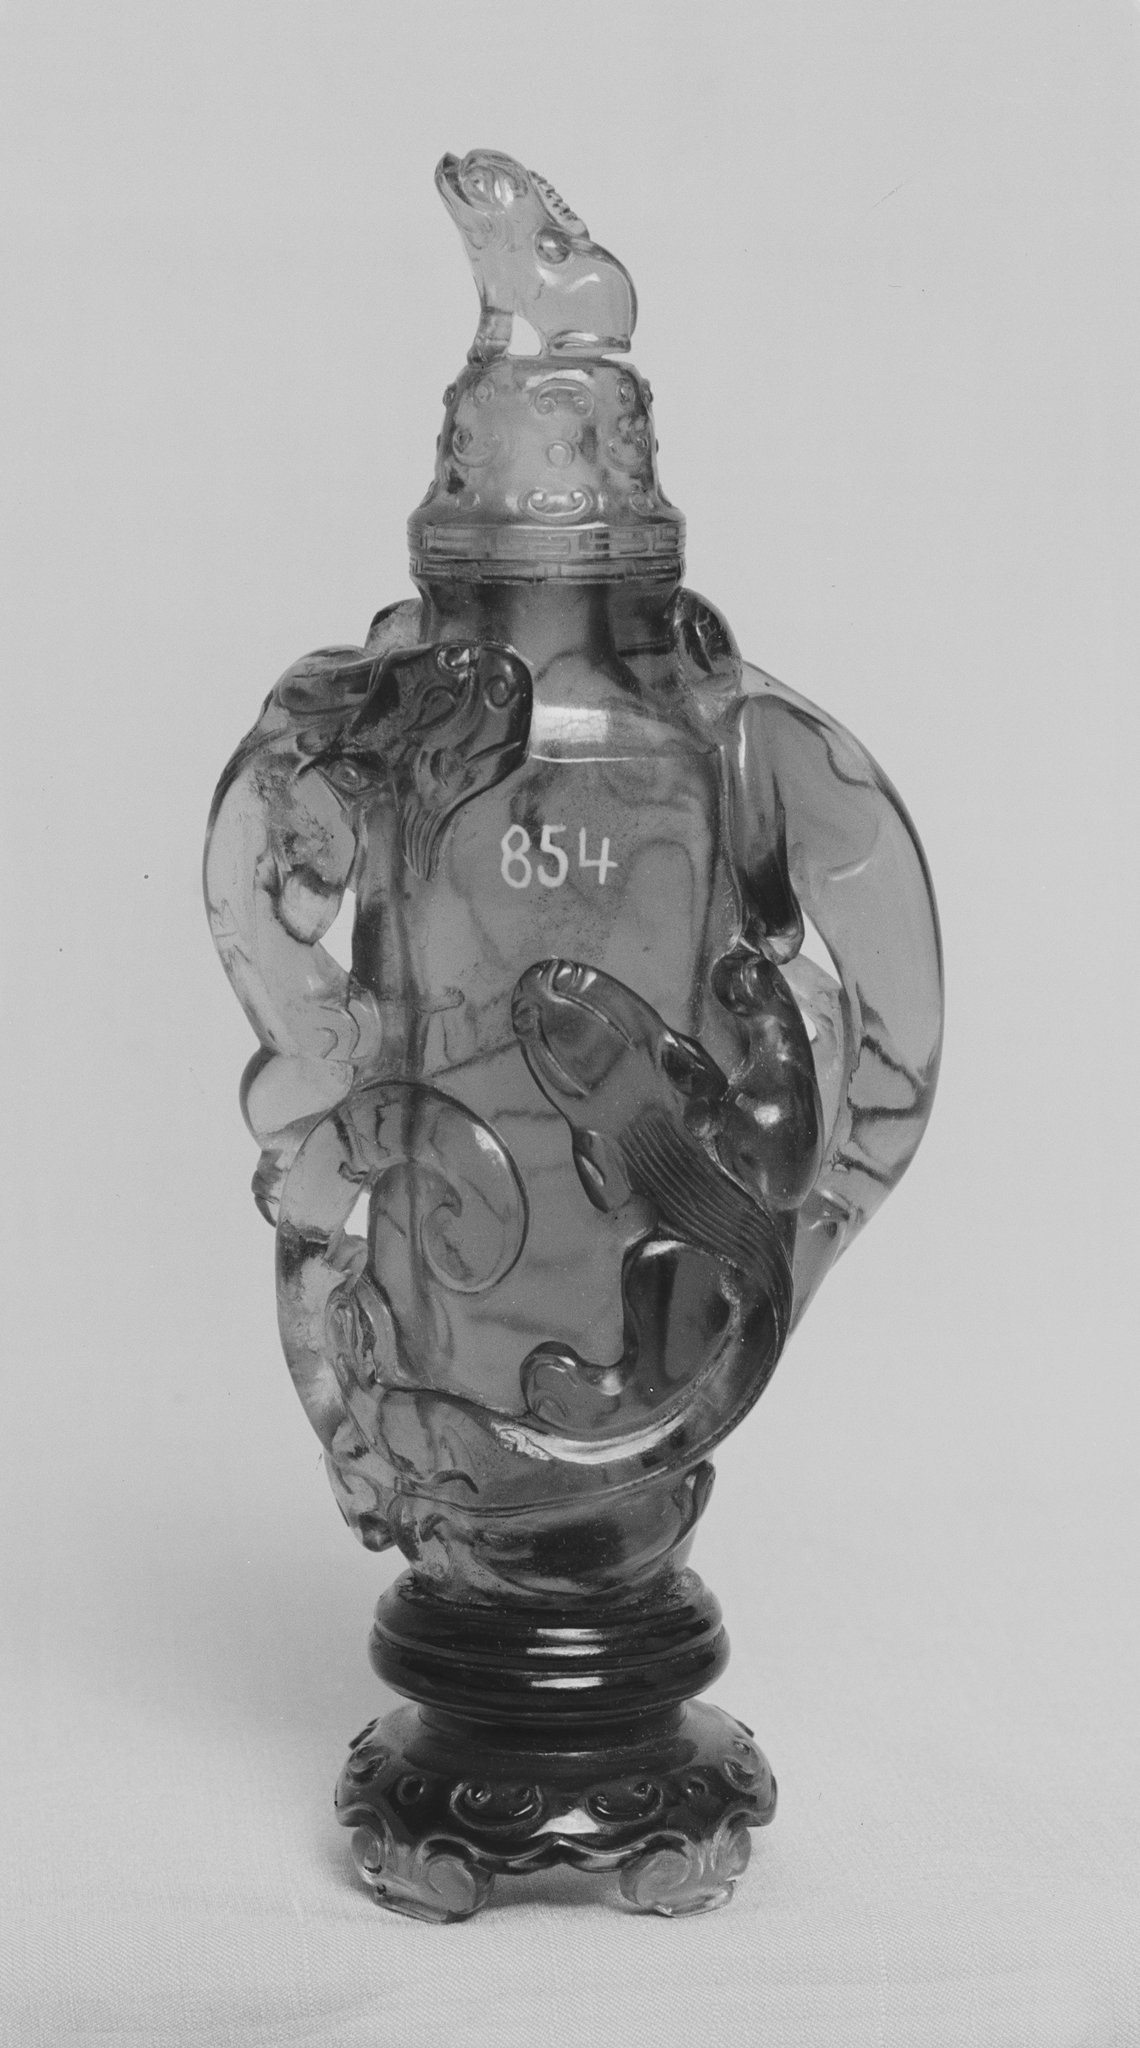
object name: vase with cover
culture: chinese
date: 1701-1800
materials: quartz